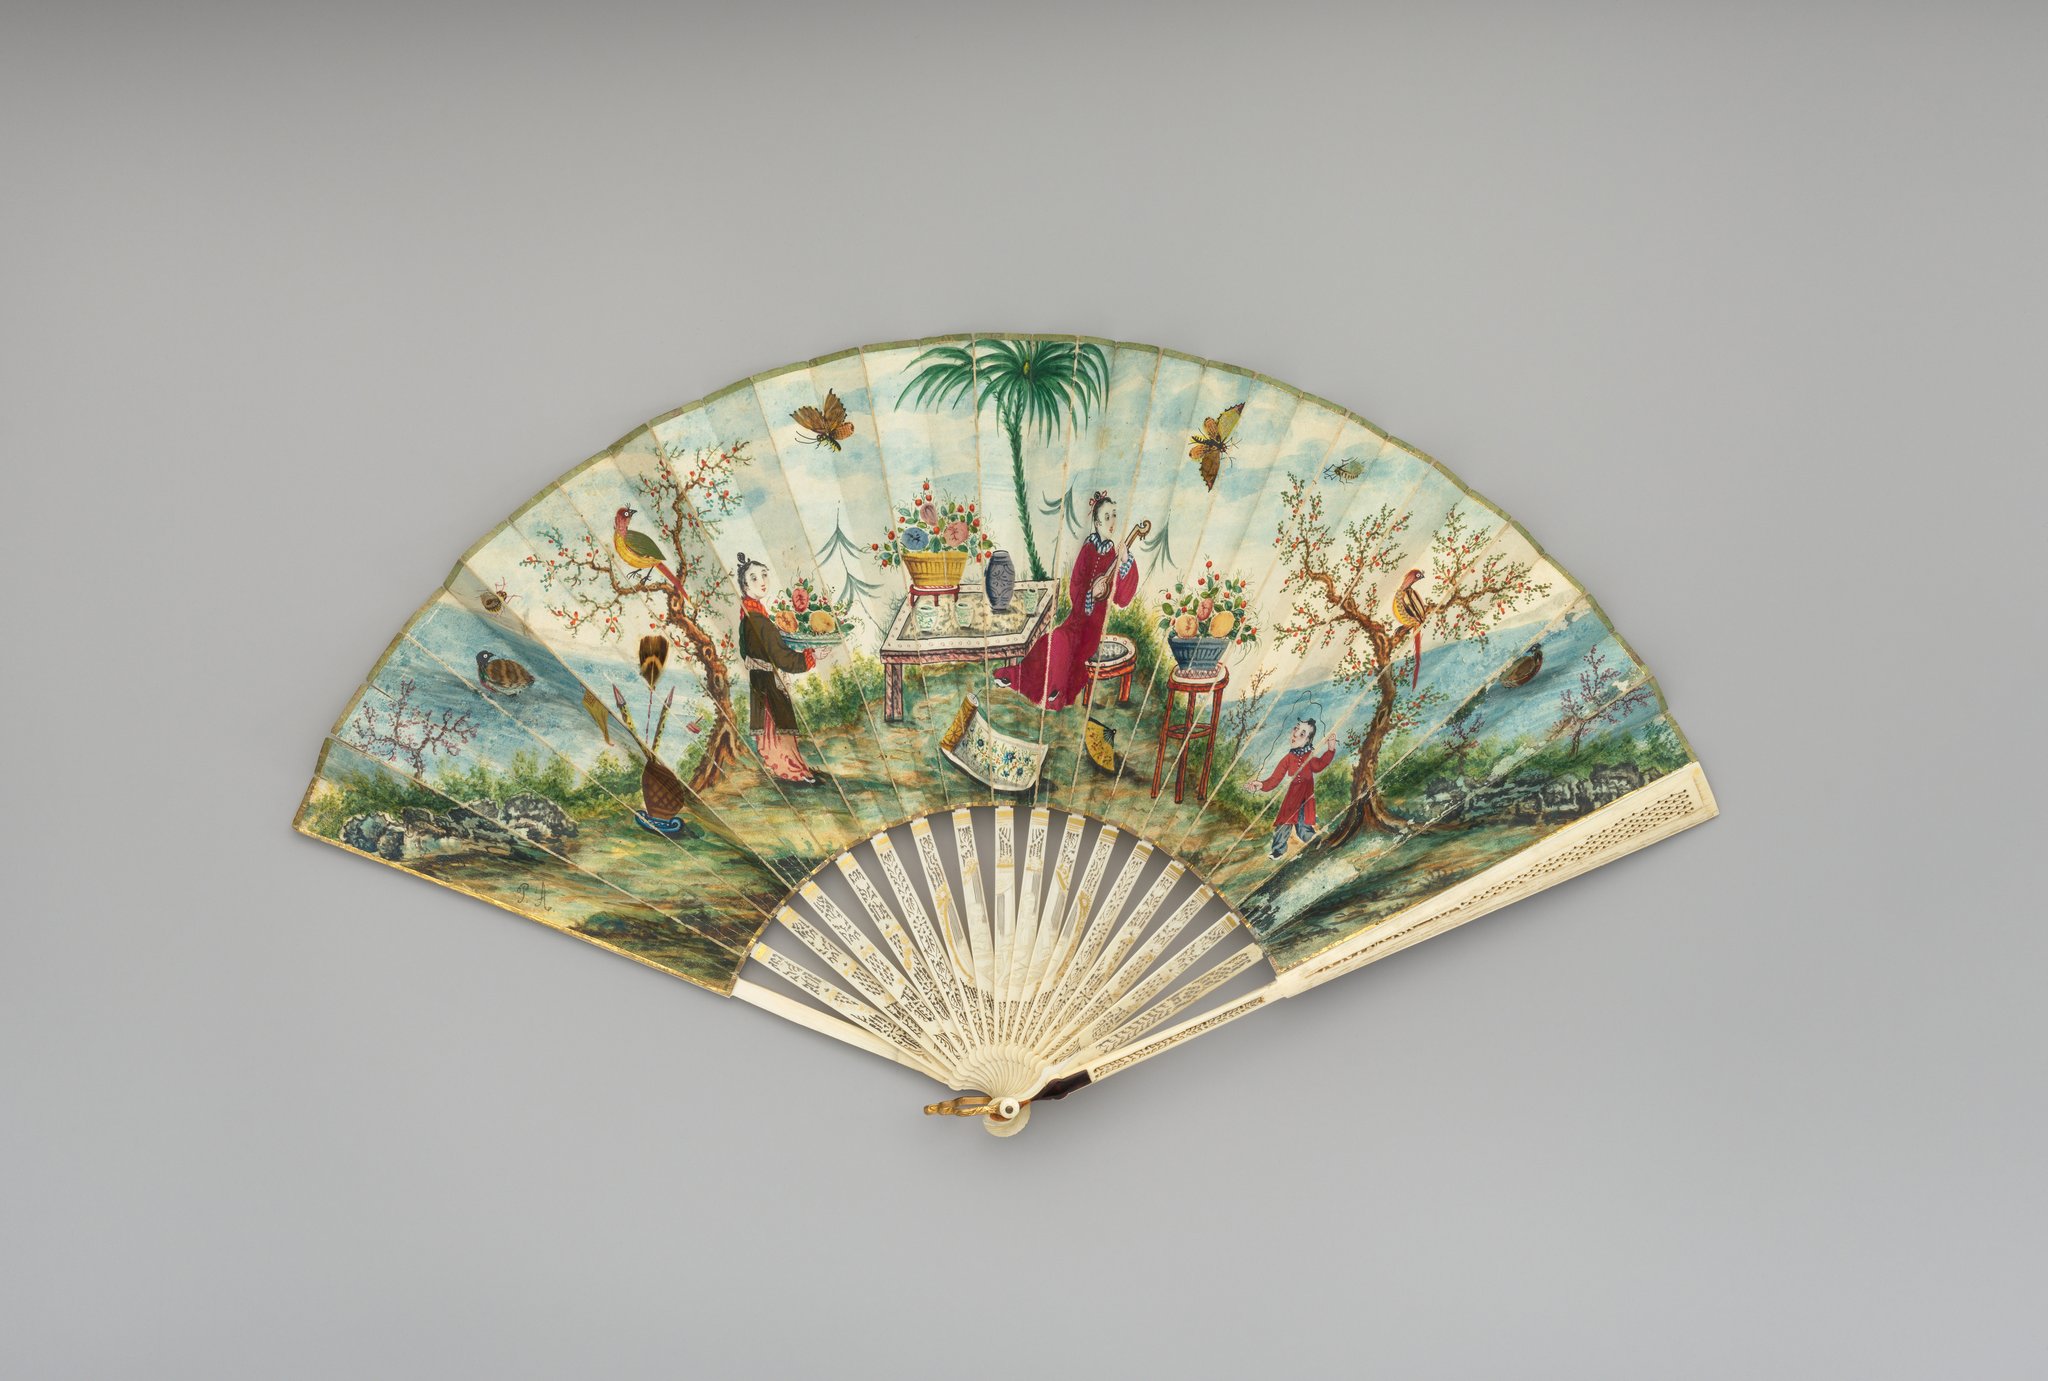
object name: fan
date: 1734-1766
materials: feather, ivory, silk, skin, shell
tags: musical instruments,birds,butterflies